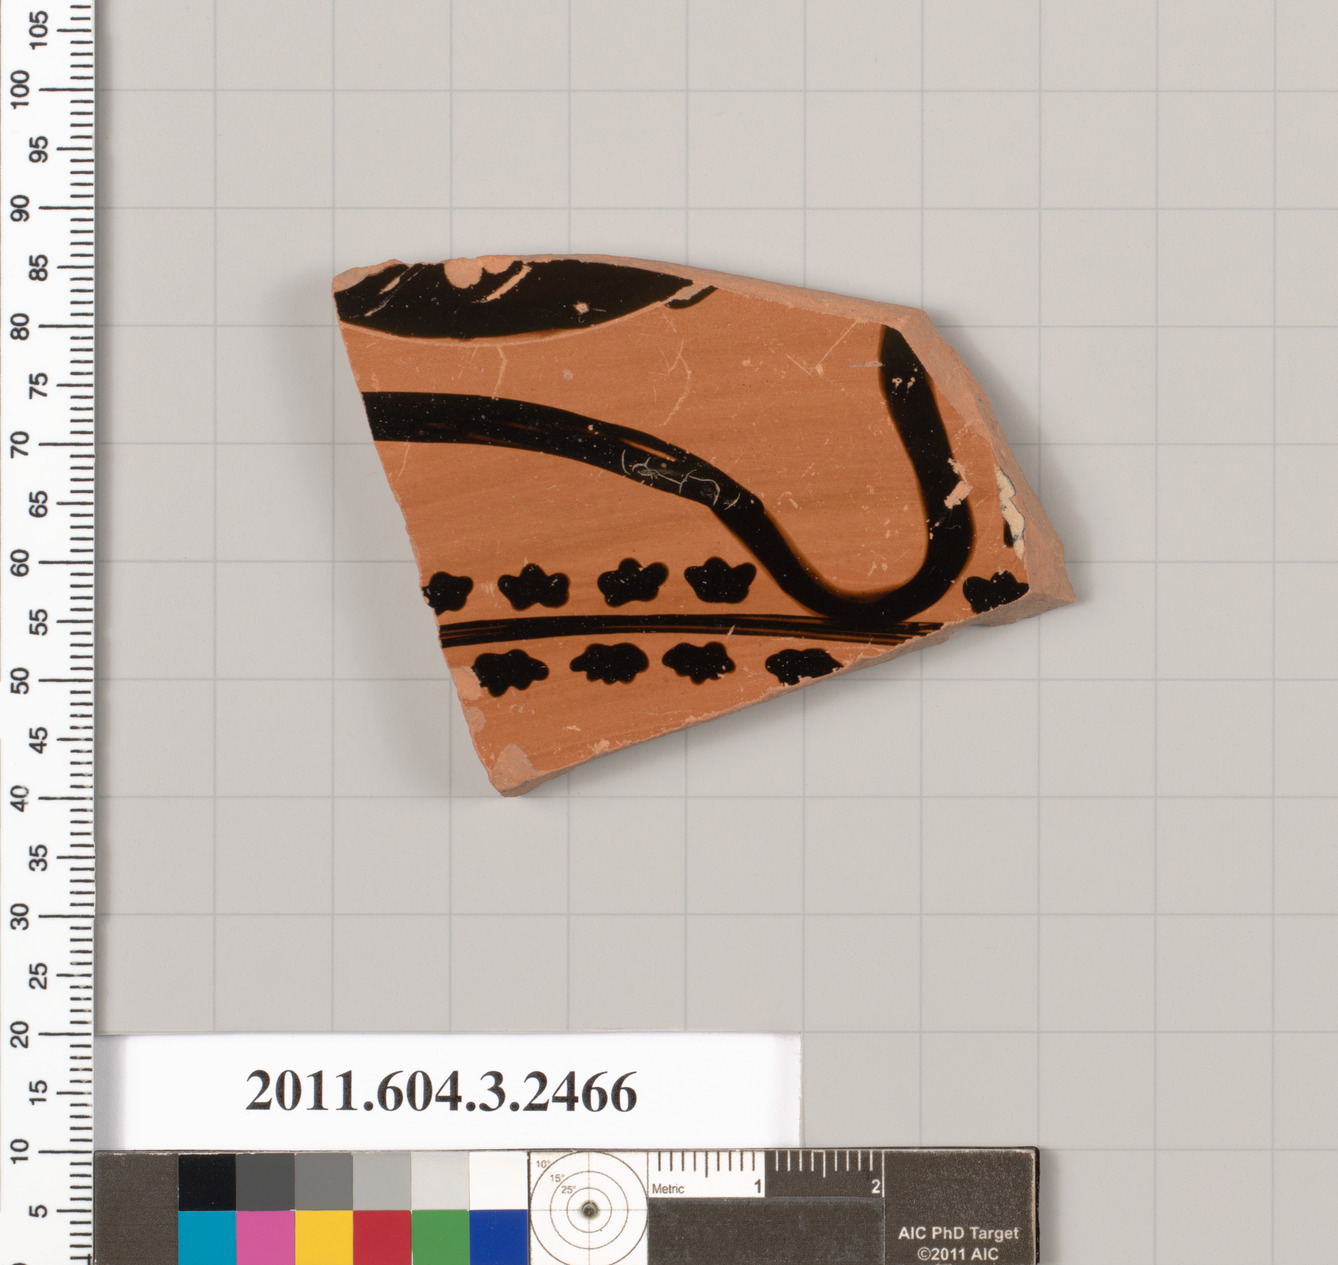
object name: kylix fragment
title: Terracotta fragment of a kylix: eye-cup (drinking cup)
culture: greek, attic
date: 520-510 BCE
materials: terracotta